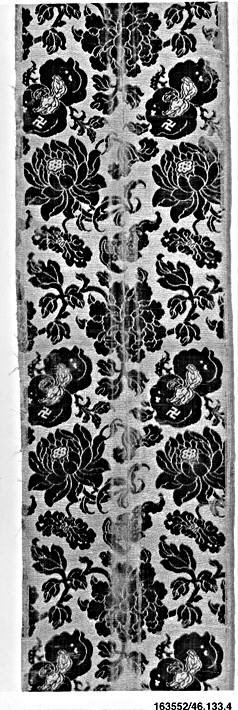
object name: piece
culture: chinese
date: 1701-1800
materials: cotton, metal thread, silk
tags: lotuses,leaves